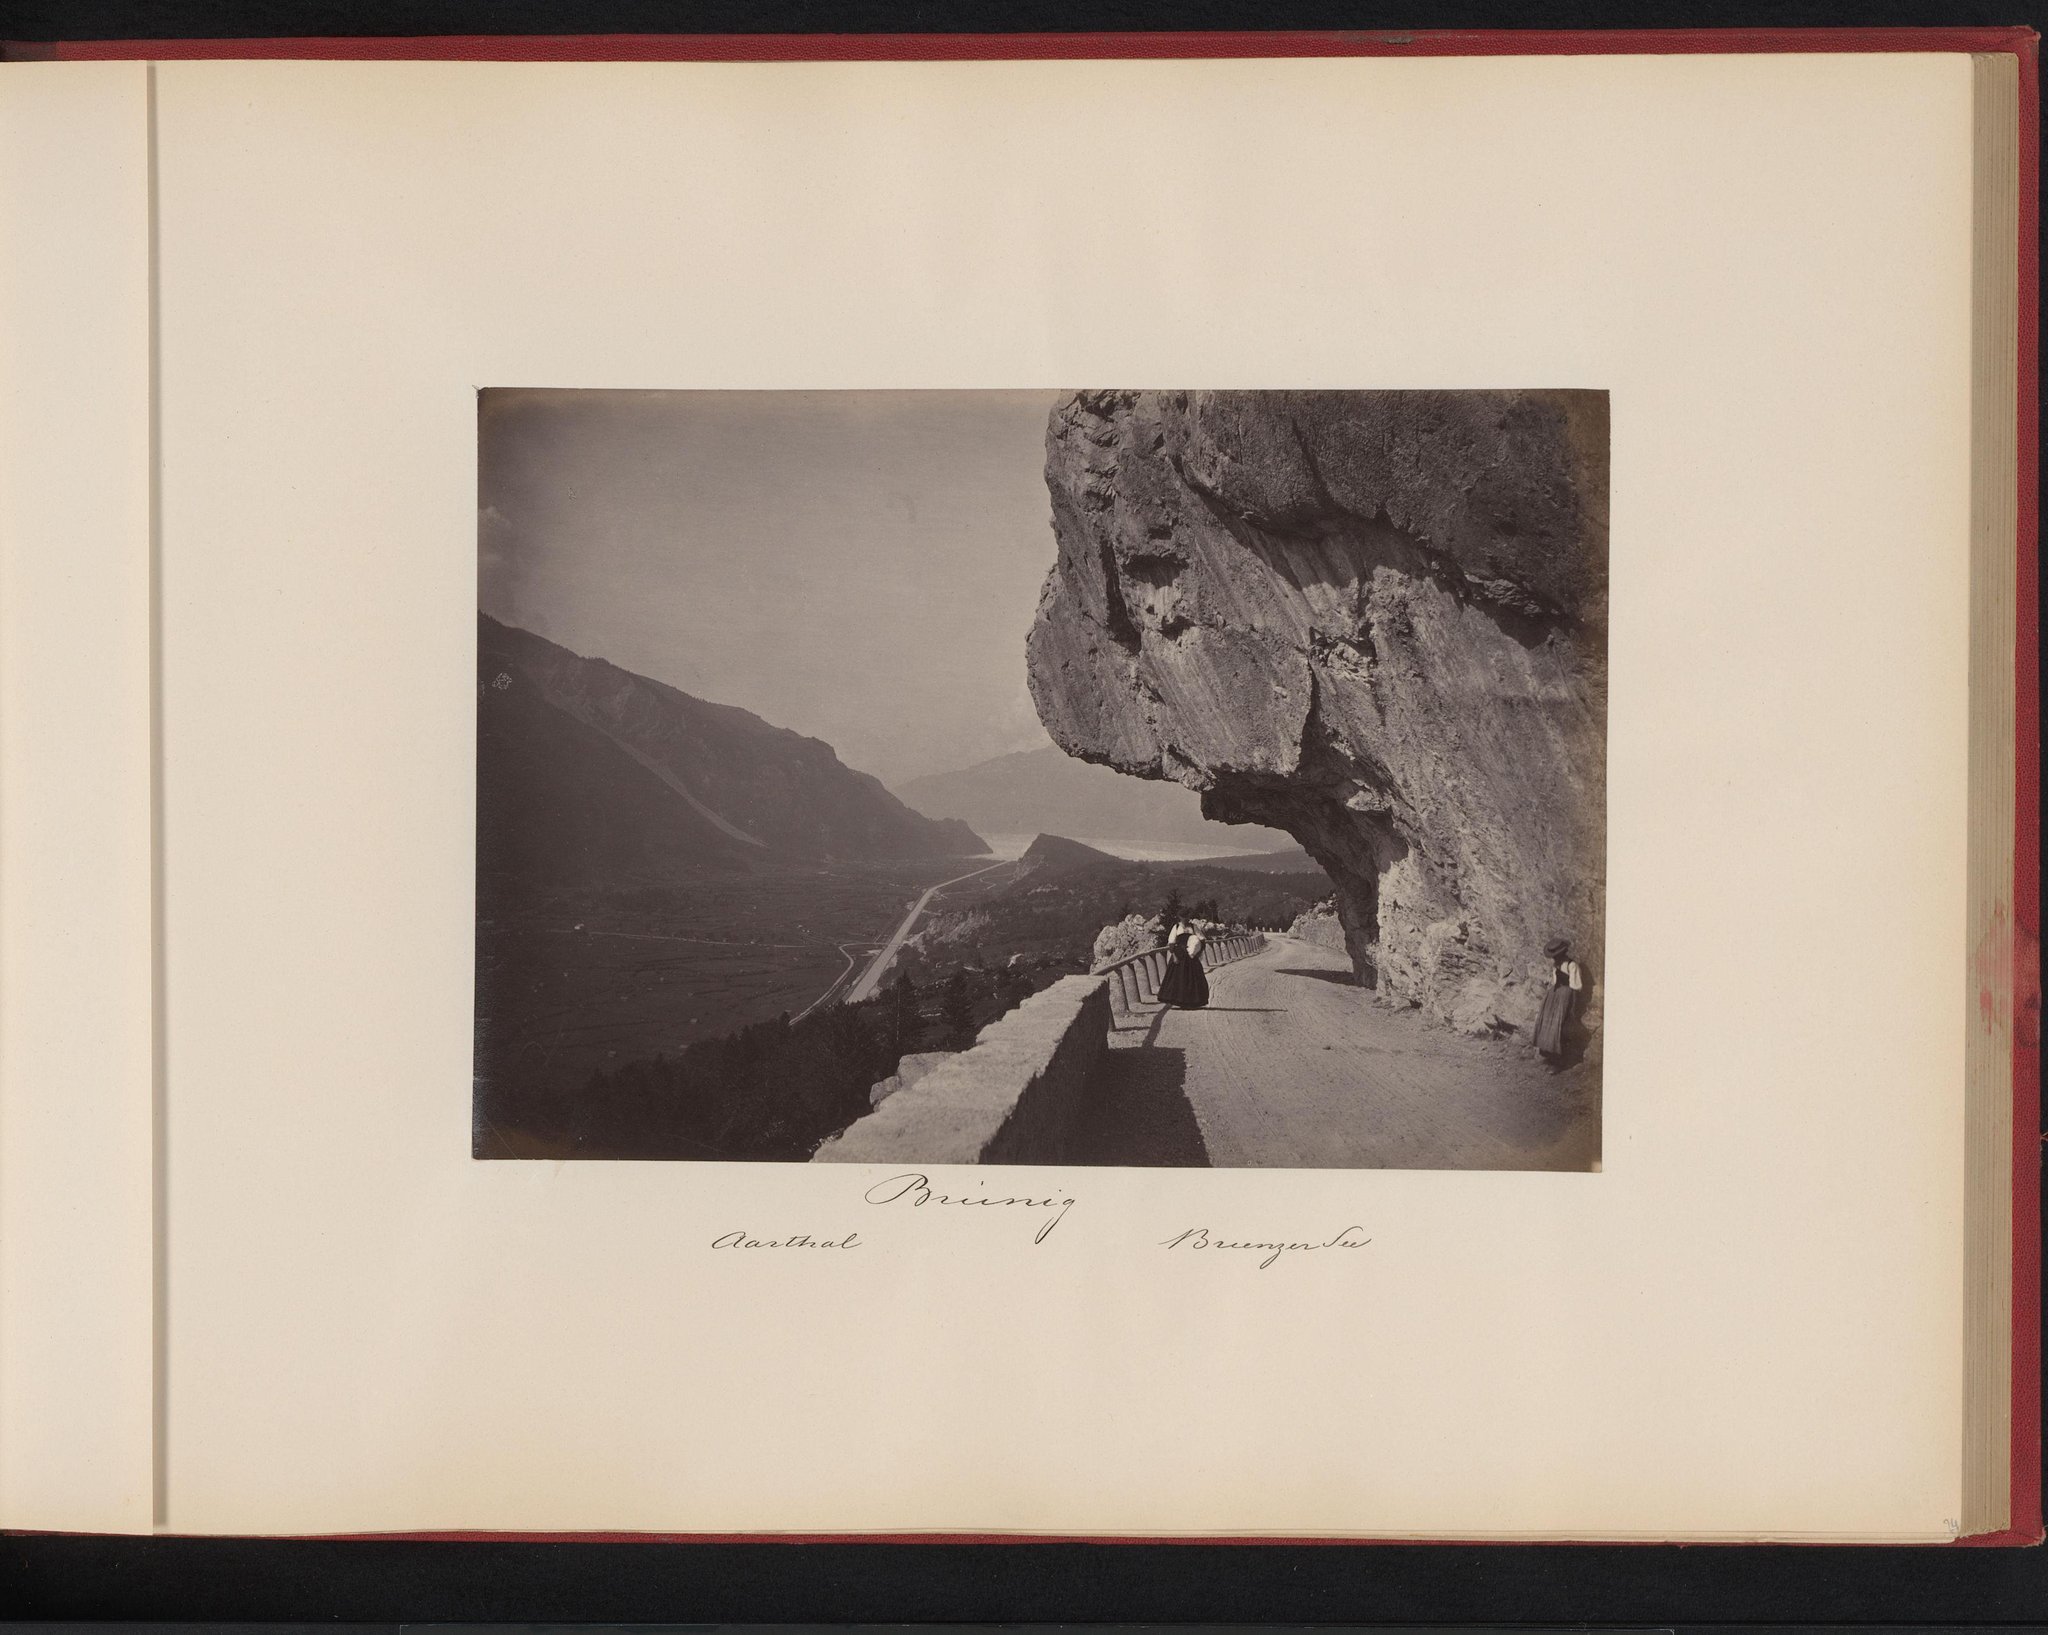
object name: album leaf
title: Gezicht op de Brienzersee te Zwitserland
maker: Anonymous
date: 1880-1900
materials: photographic support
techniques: albumen print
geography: obwalden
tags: lake, public road